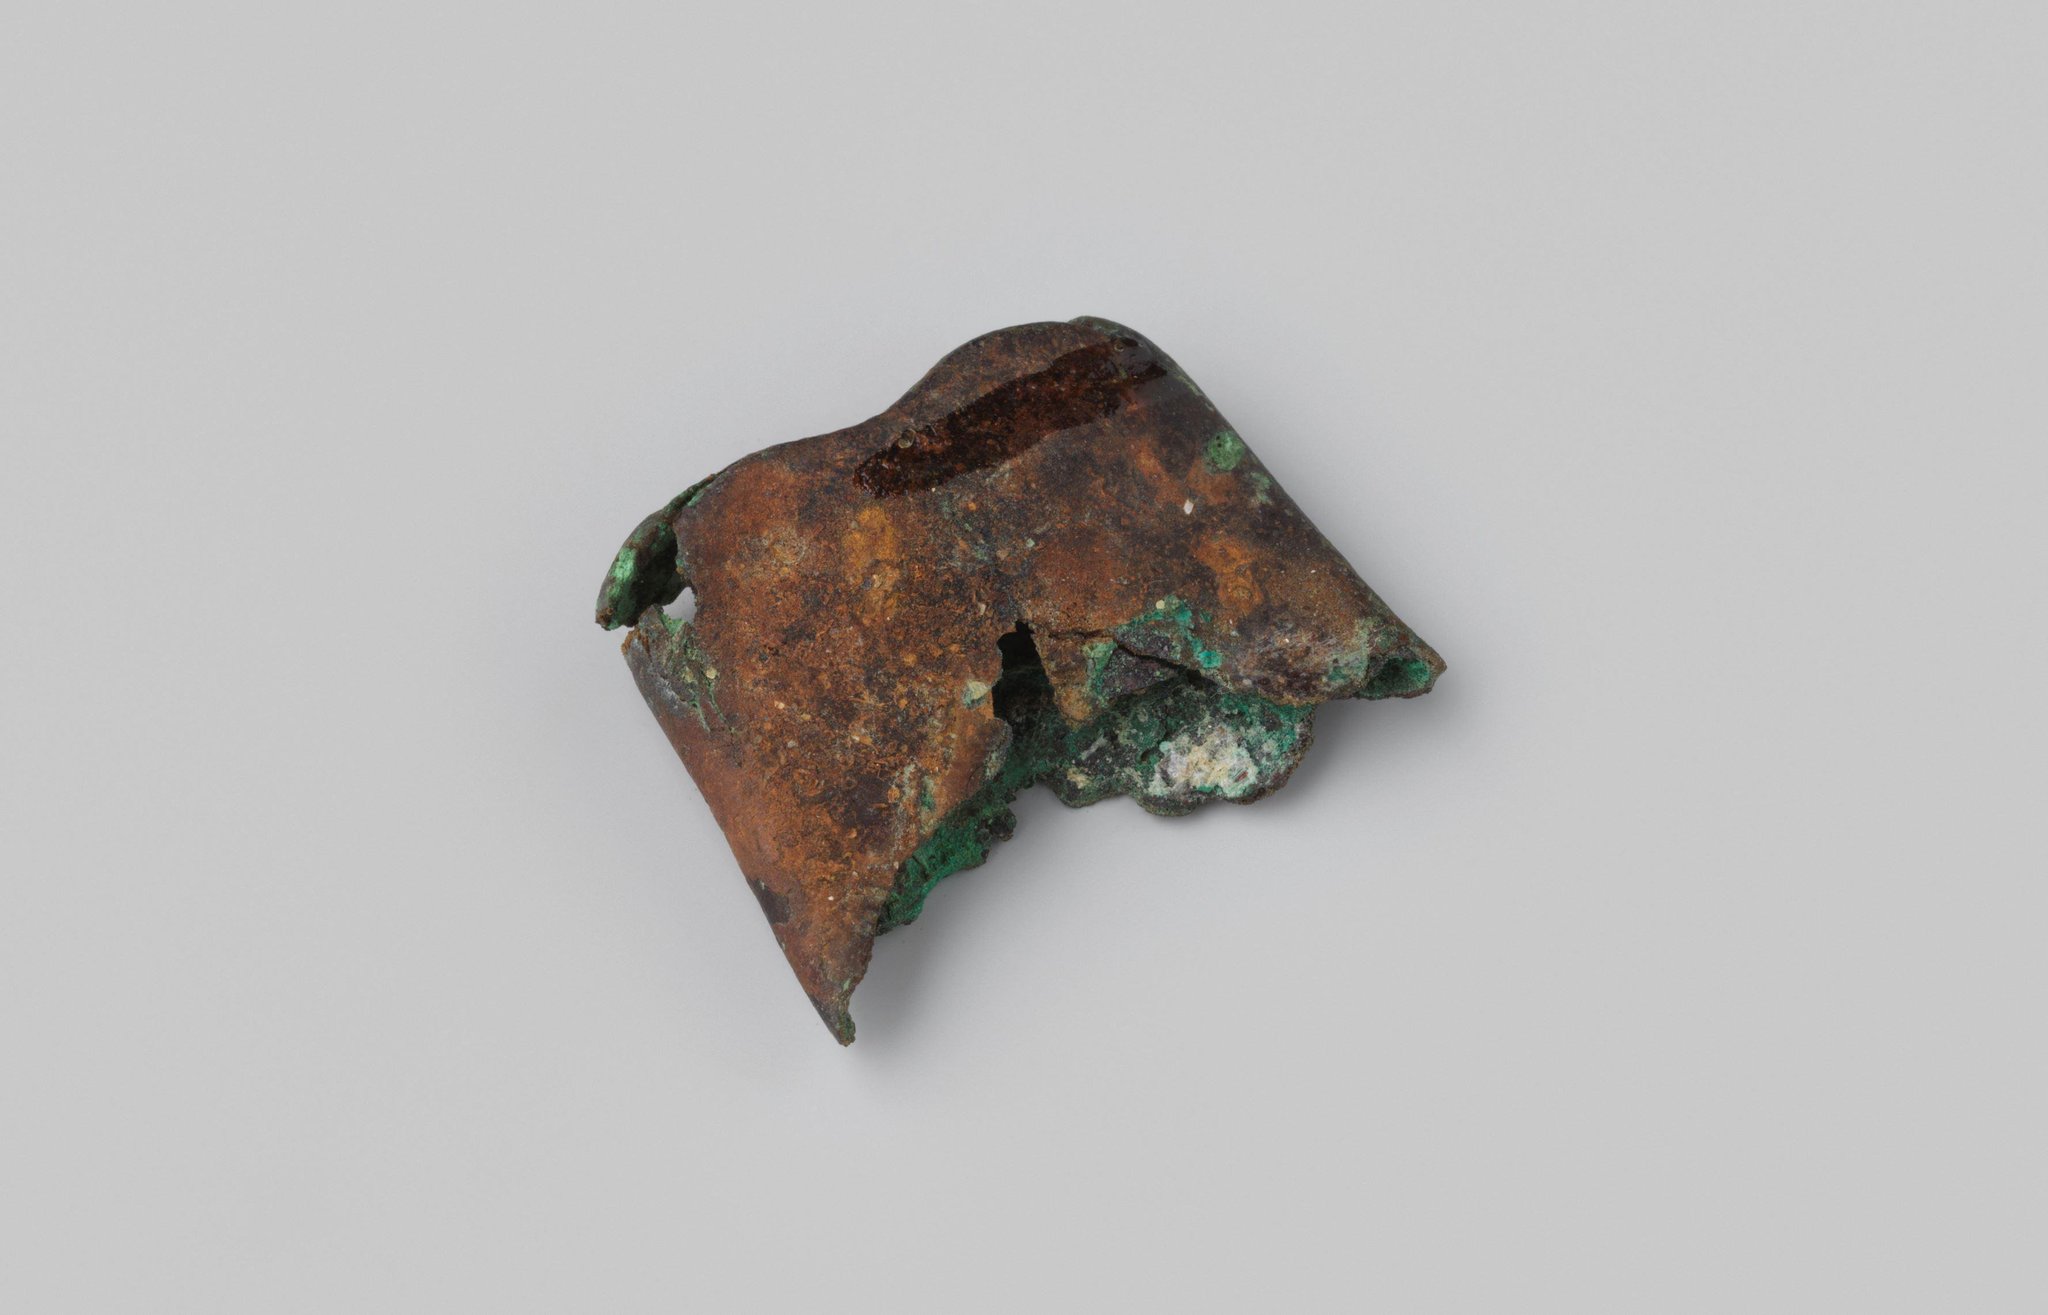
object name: clamp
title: Fragment klem afkomstig uit het wrak van de Oost-Indiëvaarder Hollandia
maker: Anonymous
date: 1700-1743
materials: copper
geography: netherlands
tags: verenigde oostindische compagnie, hollandia (schip)